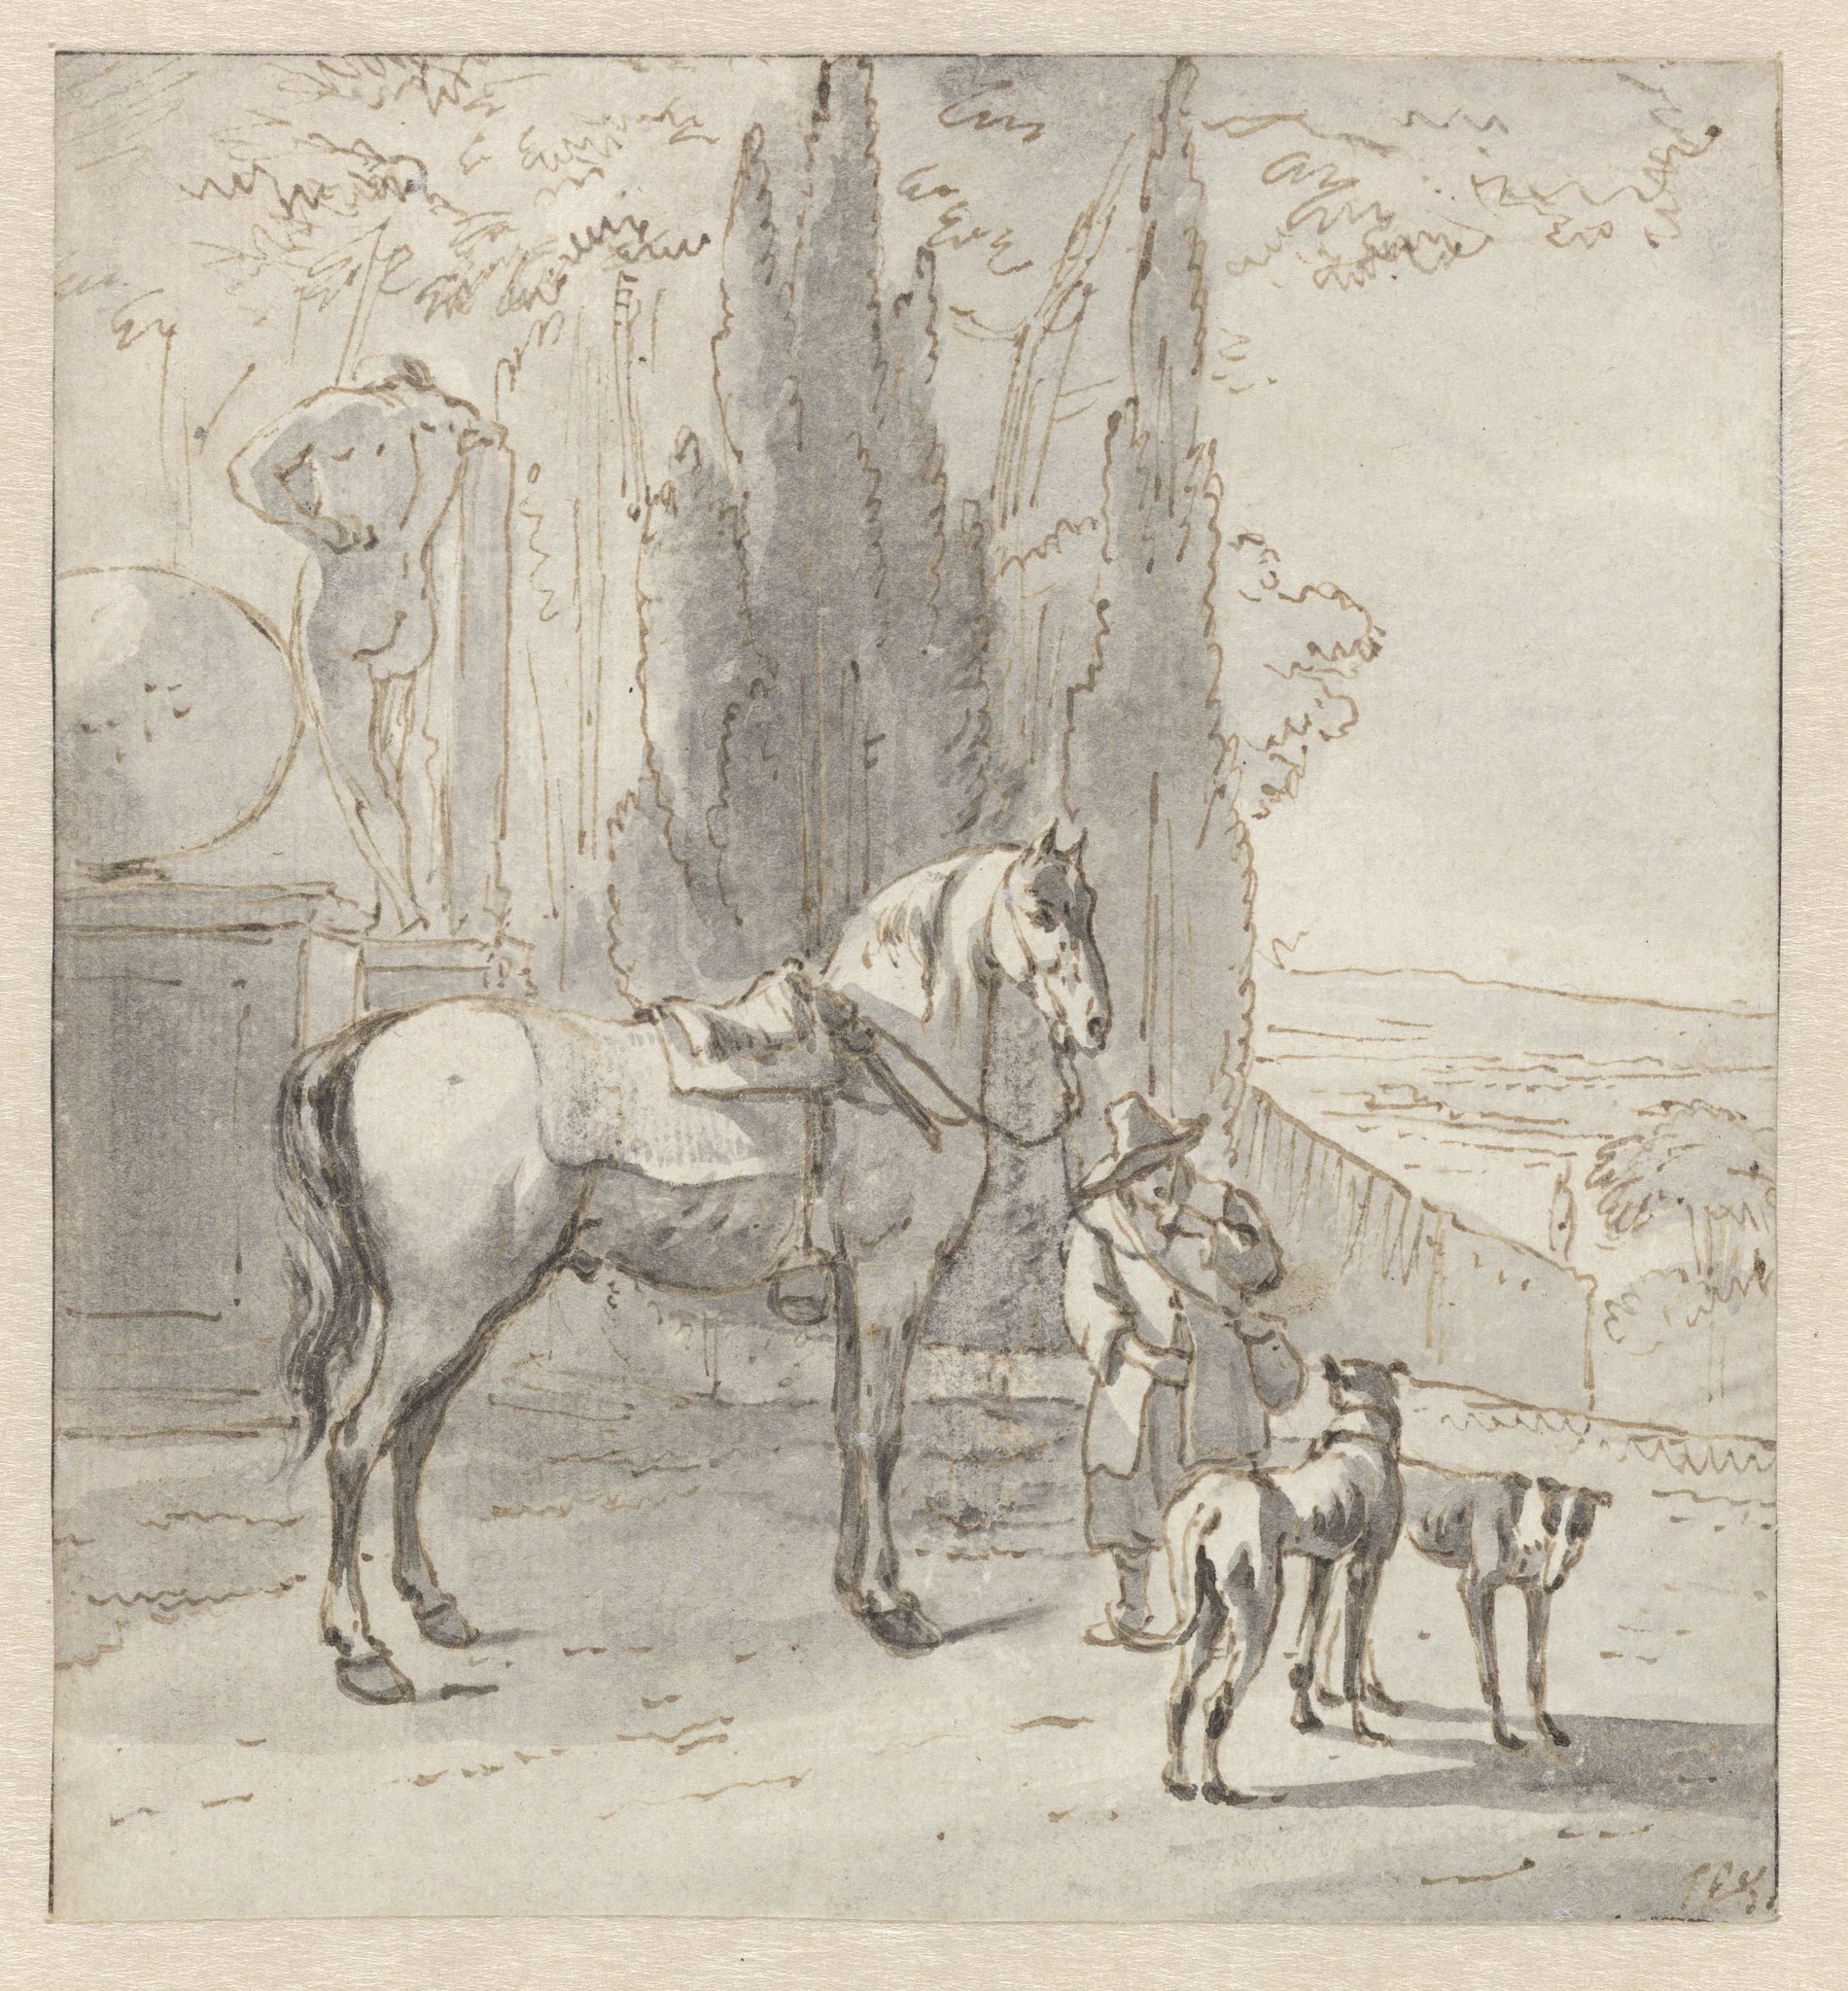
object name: drawing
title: Man met een paard en twee honden bij een park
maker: hendrik verschuring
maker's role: draughtsman, print maker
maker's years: 1627-1690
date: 1637-1690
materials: ink, paper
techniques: brush, pen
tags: leading a horse by the reins; rider beside his horse, dog